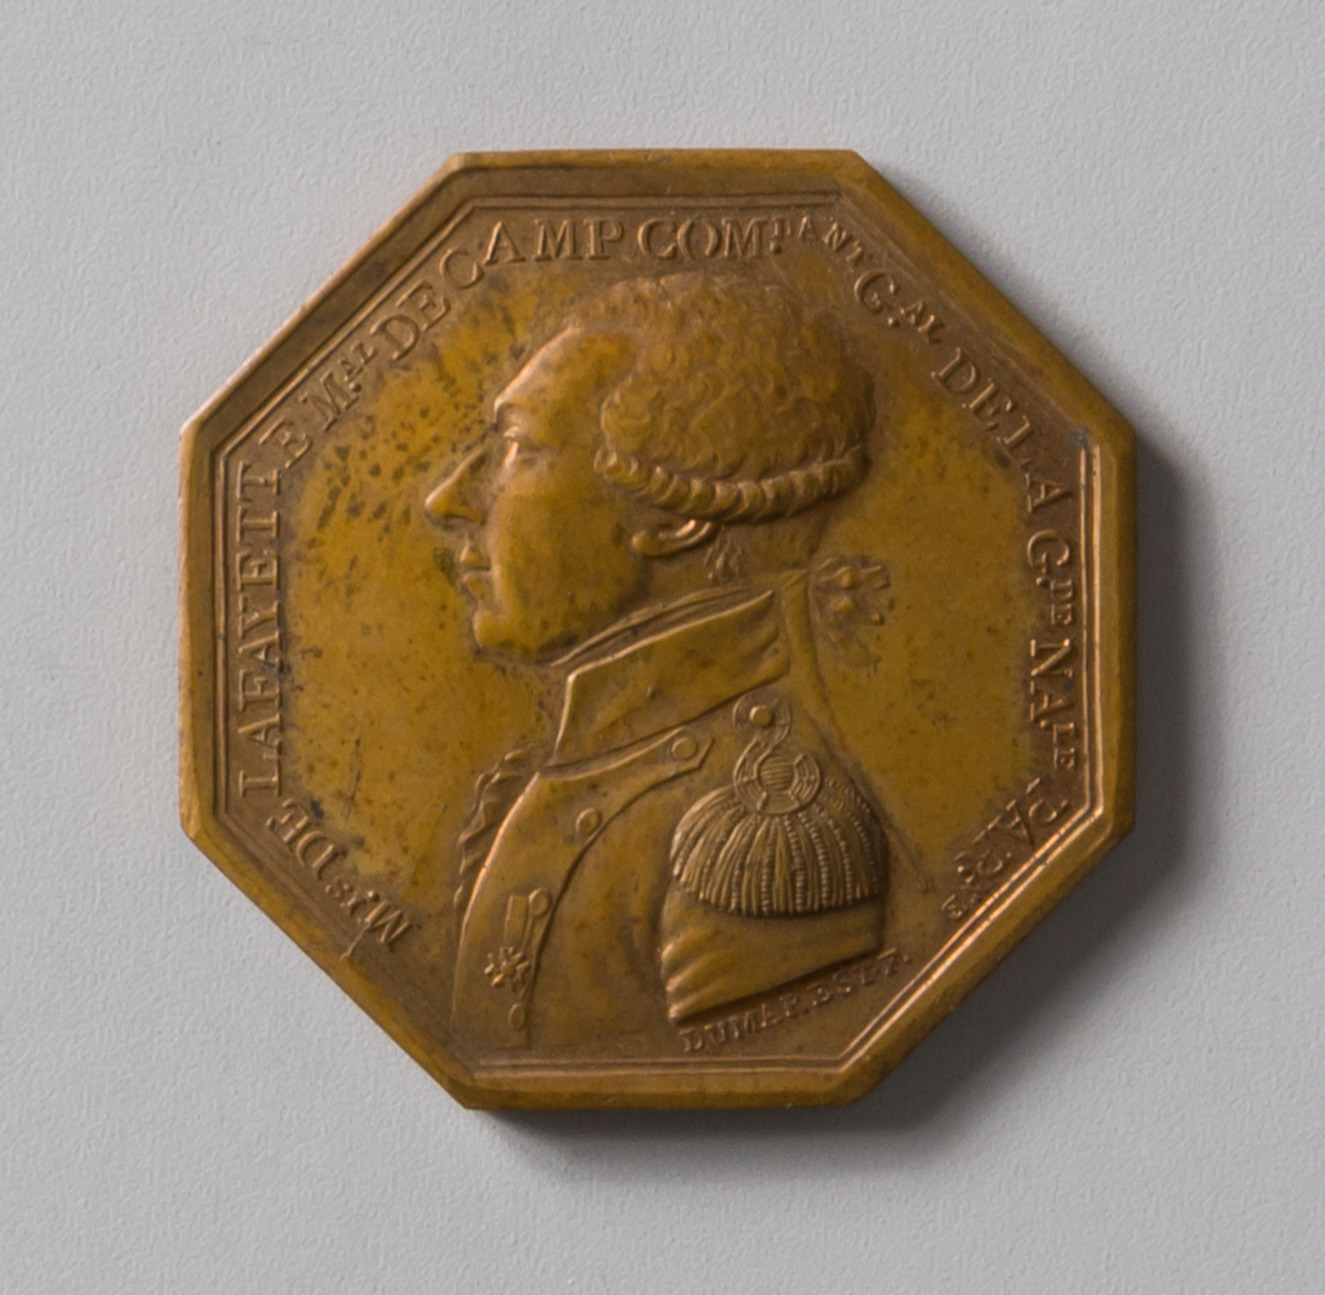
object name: plaque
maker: rambert dumarest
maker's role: maker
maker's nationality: french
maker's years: 1760-1806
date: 1789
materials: gilt bronze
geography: france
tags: men,portraits,profiles